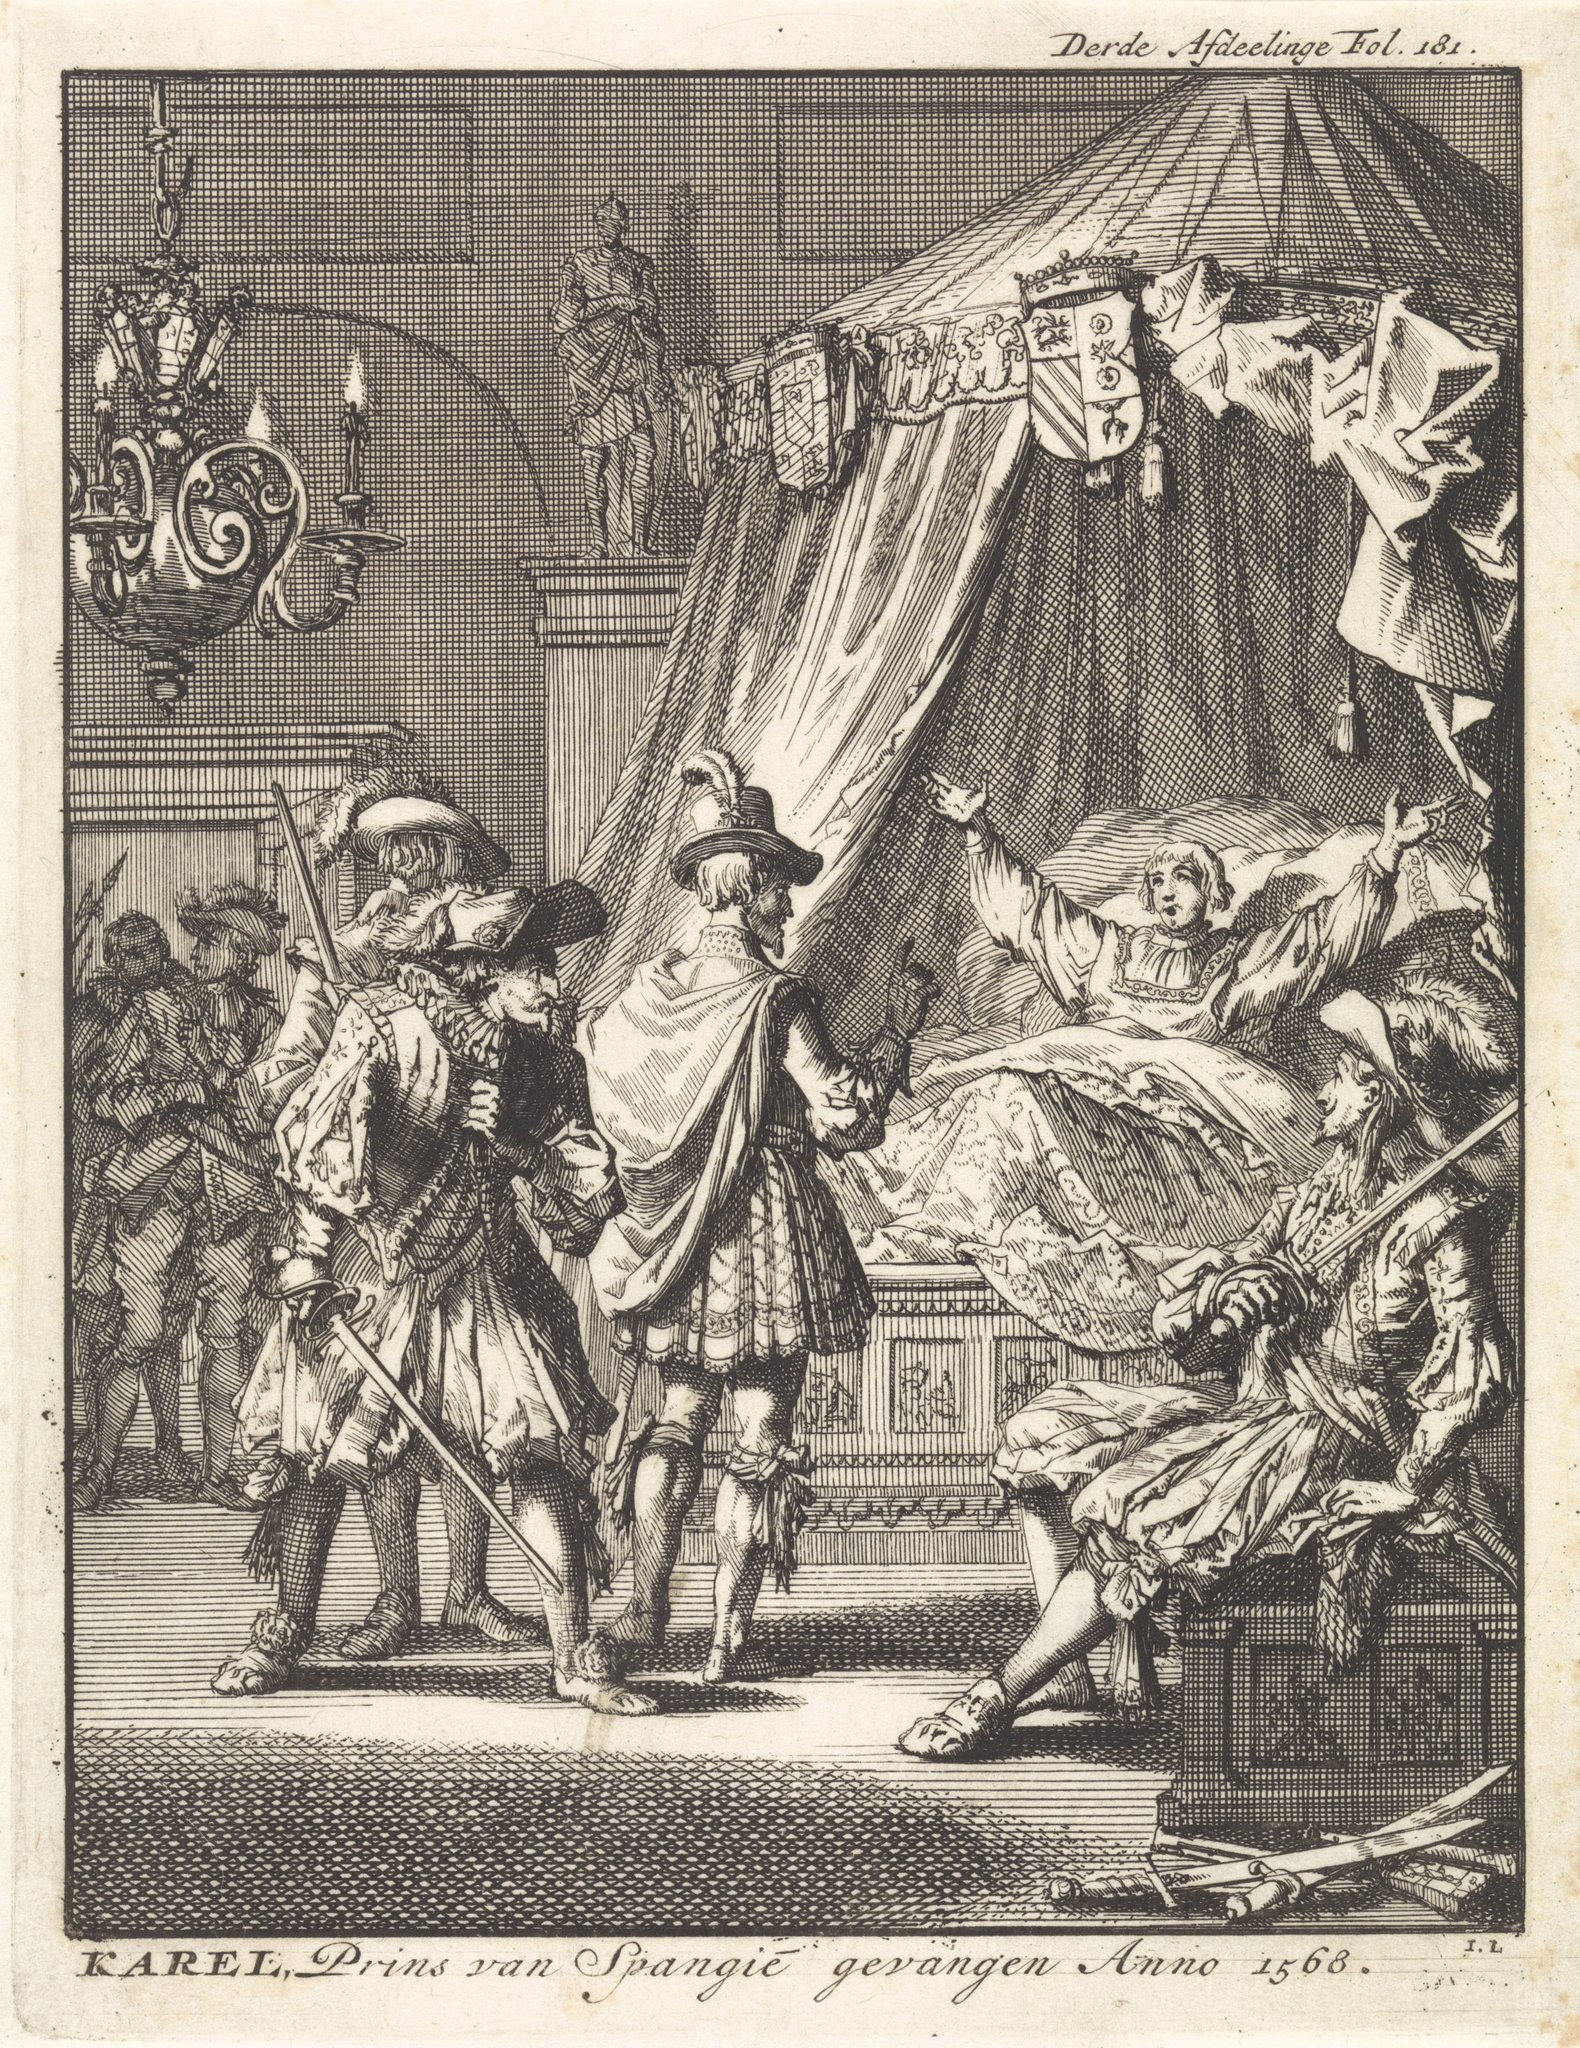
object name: book illustration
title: Karel, Prins van Spagnie gevangen Anno 1568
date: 1698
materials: paper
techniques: etching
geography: amsterdam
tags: arrest (of criminal)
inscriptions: collector's mark: Lugt 2228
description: Illustratie uit: Bos, Lambert van den. Treur-toonneel der doorluchtige mannen, of Op- en ondergang der grooten, 3 delen. Amsterdam: Jan Claesz ten Hoorn, 1698, dl. II.